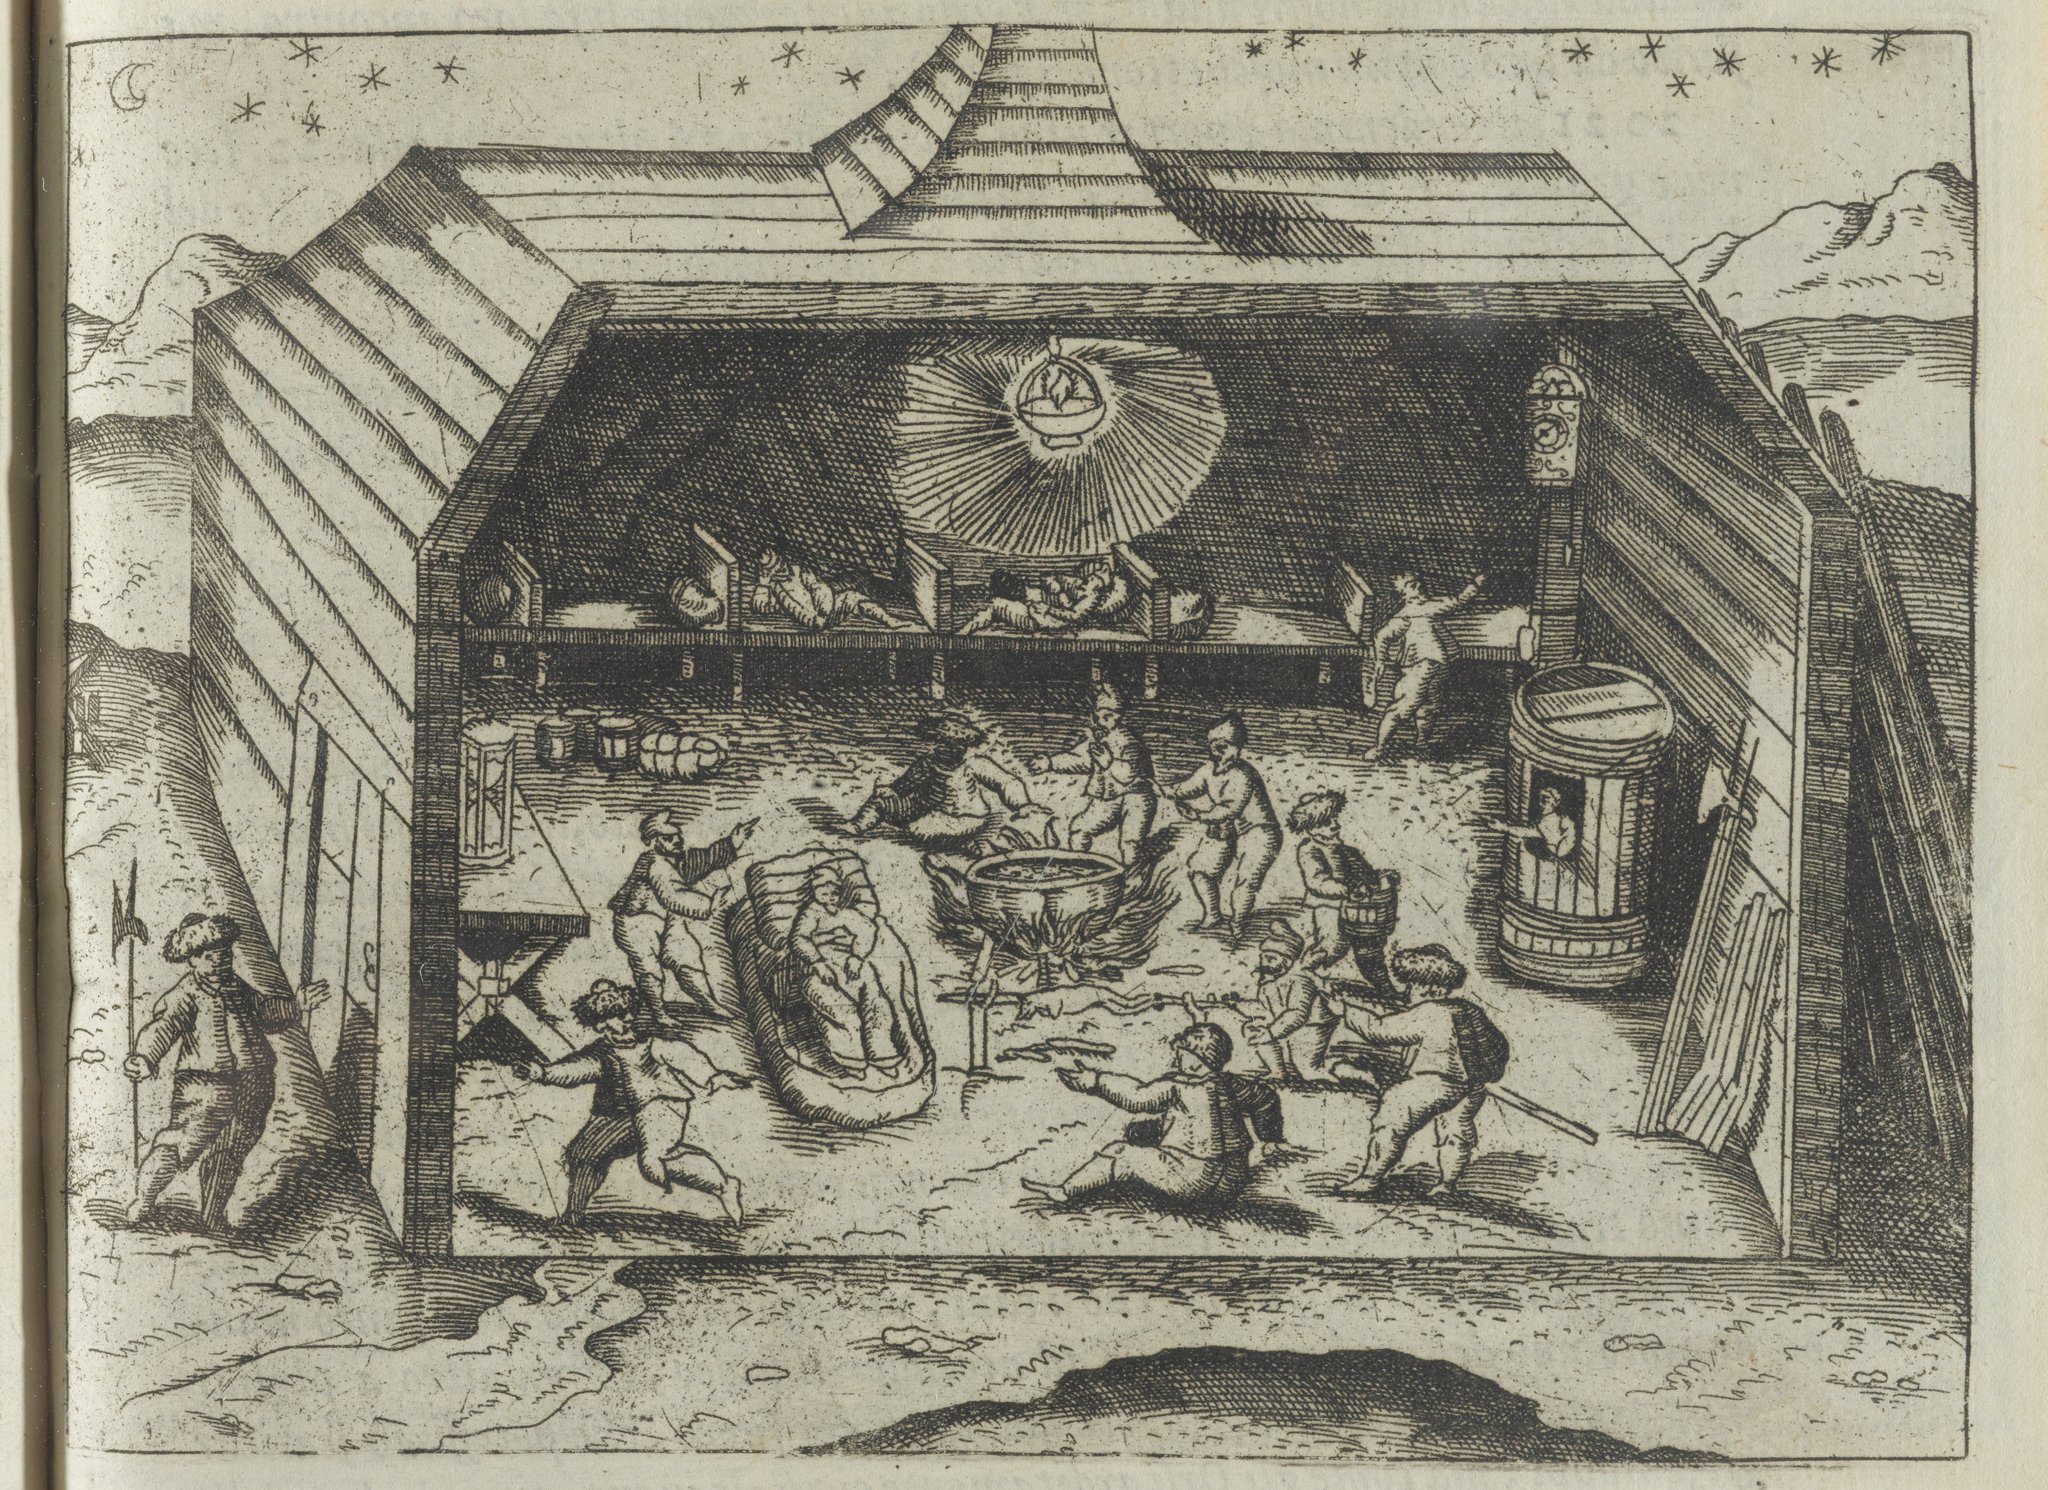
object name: book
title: Tre Navigationi fatte dagli Olandesi, e Zelandesi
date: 1599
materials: paper, parchment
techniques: bookbinding, printing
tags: indië, noordoostelijke doorvaartpogingen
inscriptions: date: ‘1599’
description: 79 genummerde bladen (158 pagina's) in beige perkamenten band.